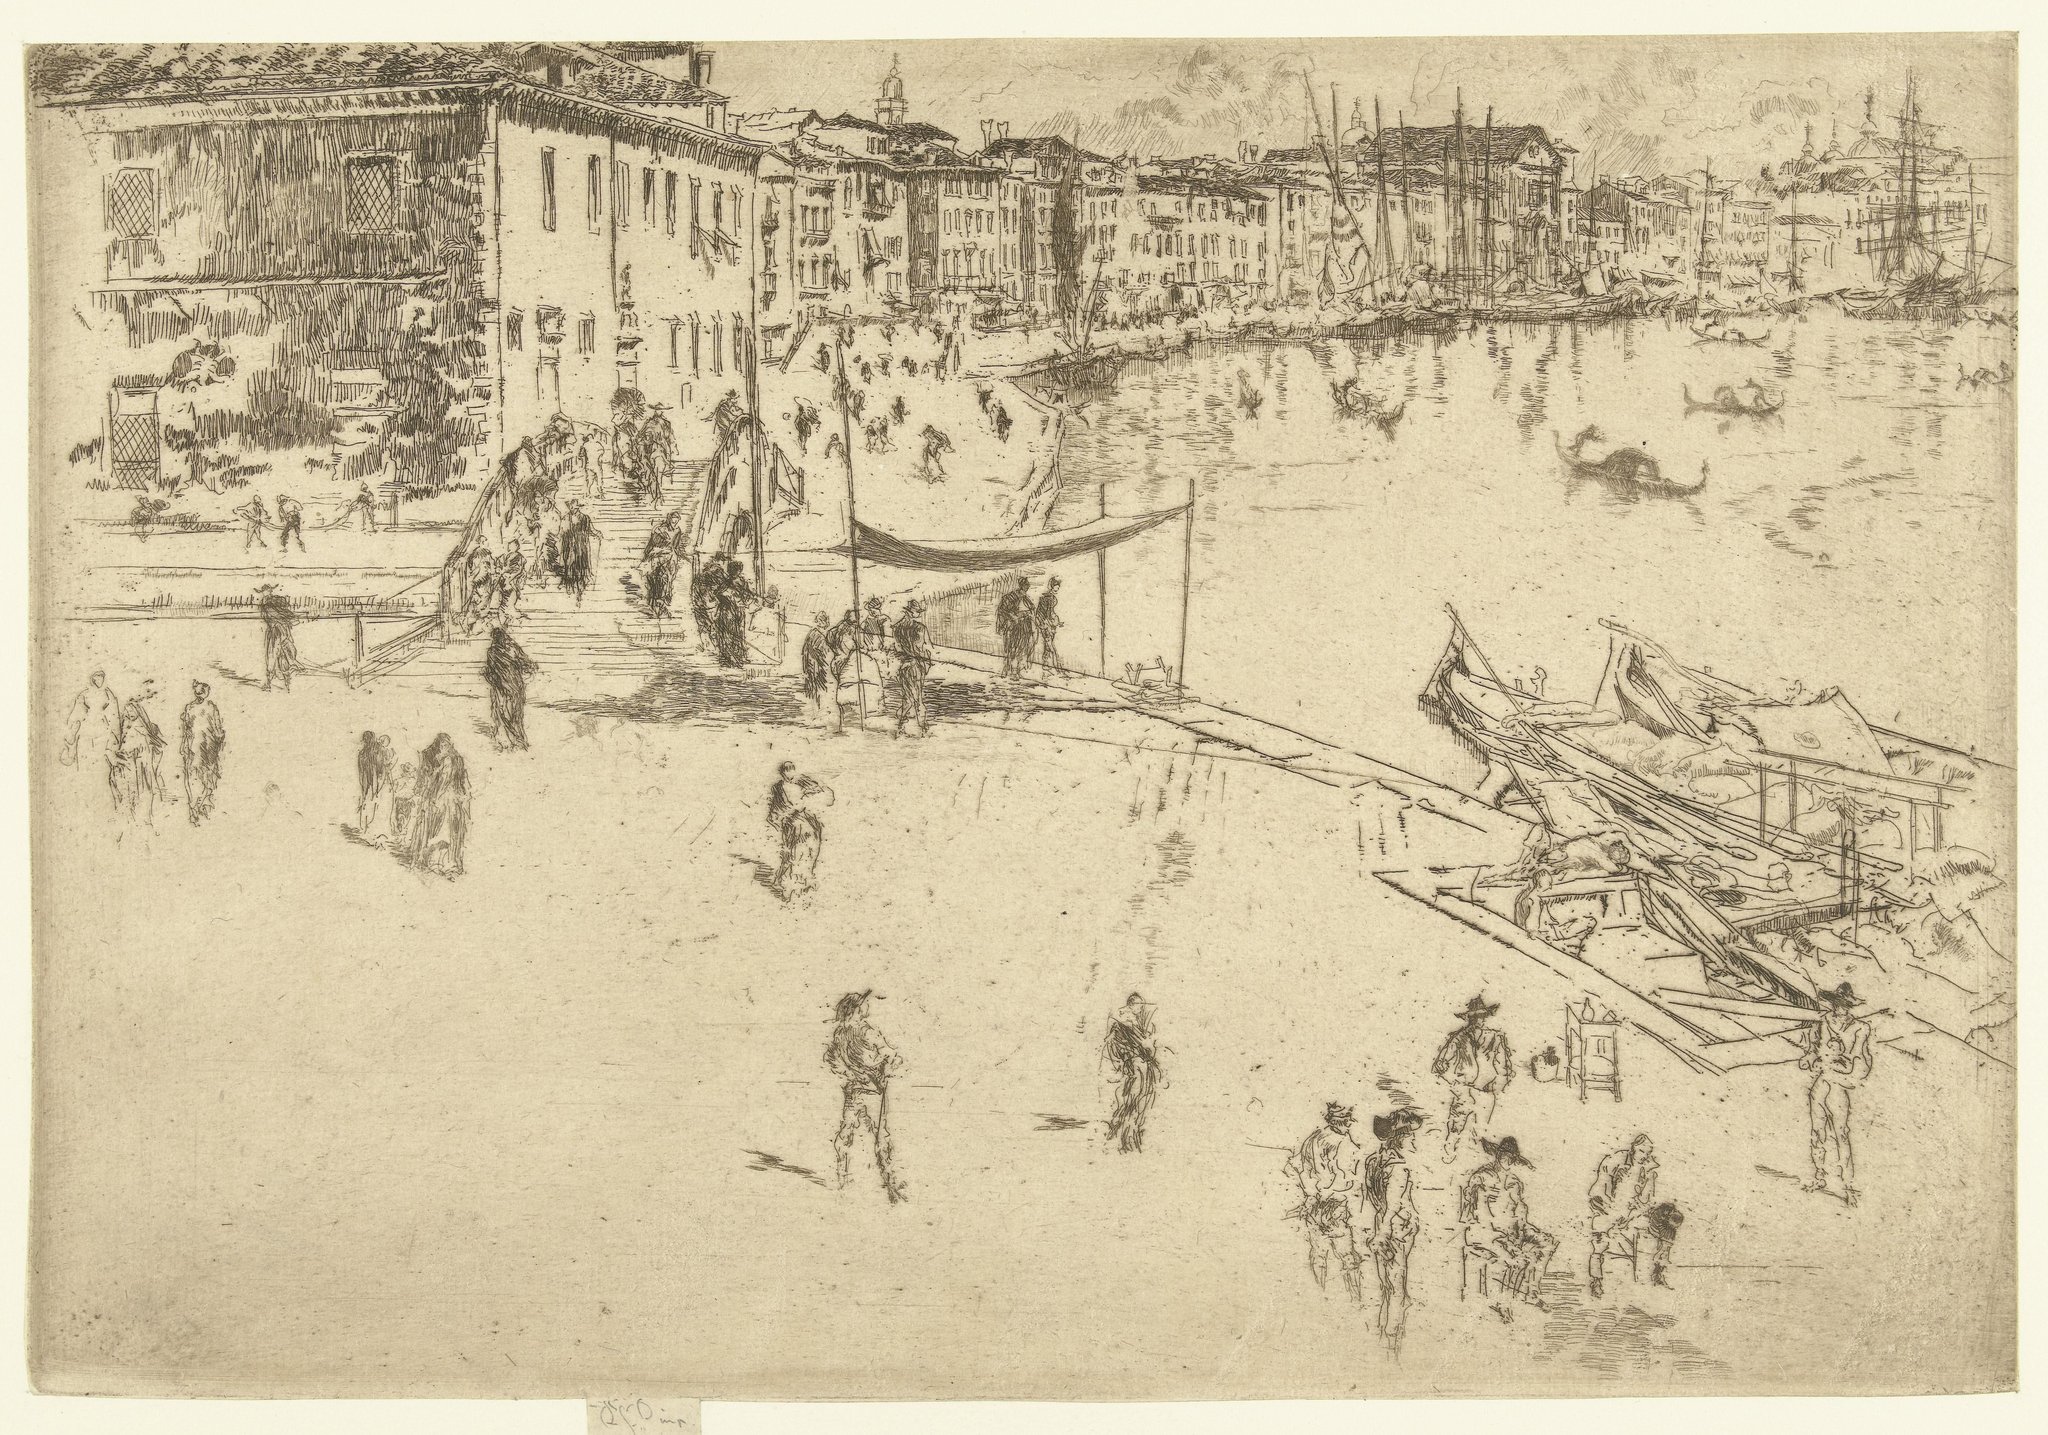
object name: print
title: Riva del Sciavoni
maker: james abbott mcneill whistler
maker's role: painter, print maker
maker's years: 1834-1903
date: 1879-1880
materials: paper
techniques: drypoint, etching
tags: quay, venice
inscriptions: signature: ‘JW imp’, collector's mark: Lugt 2760, collector's mark: Lugt 2228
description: Deze prent was onderdeel van "A set of twenty-six etchings", uitgegeven door Dowdeswell in 1886 te Londen. Botke, K.